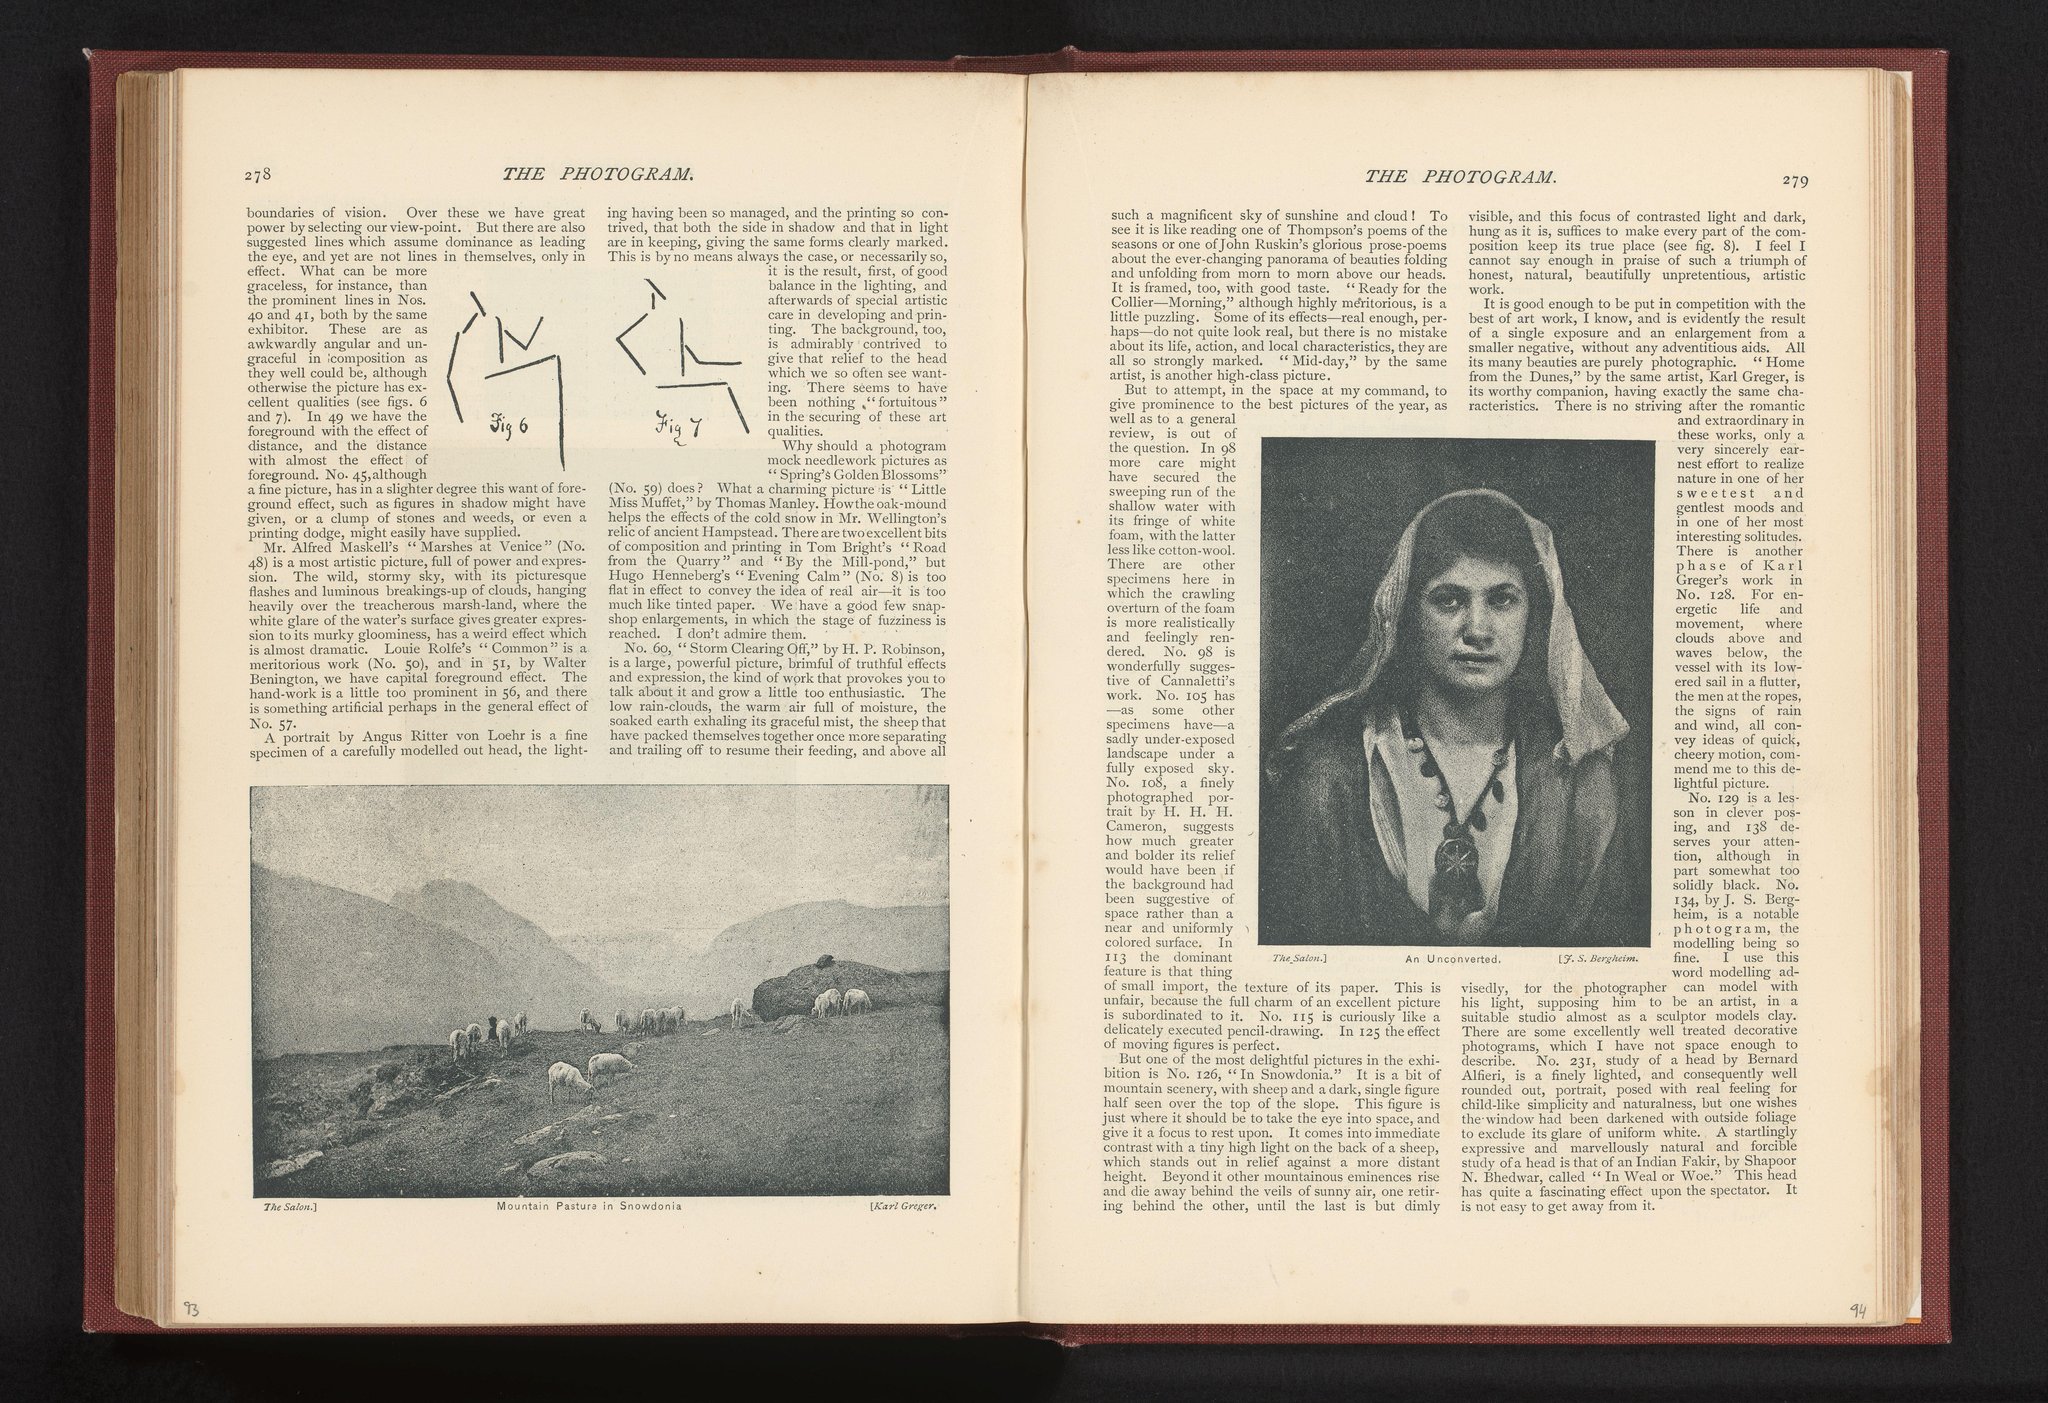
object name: page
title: Portret van een onbekende vrouw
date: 1889-1894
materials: paper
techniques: autotype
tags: historical persons - bb - woman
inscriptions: inscription: ‘The Salon’